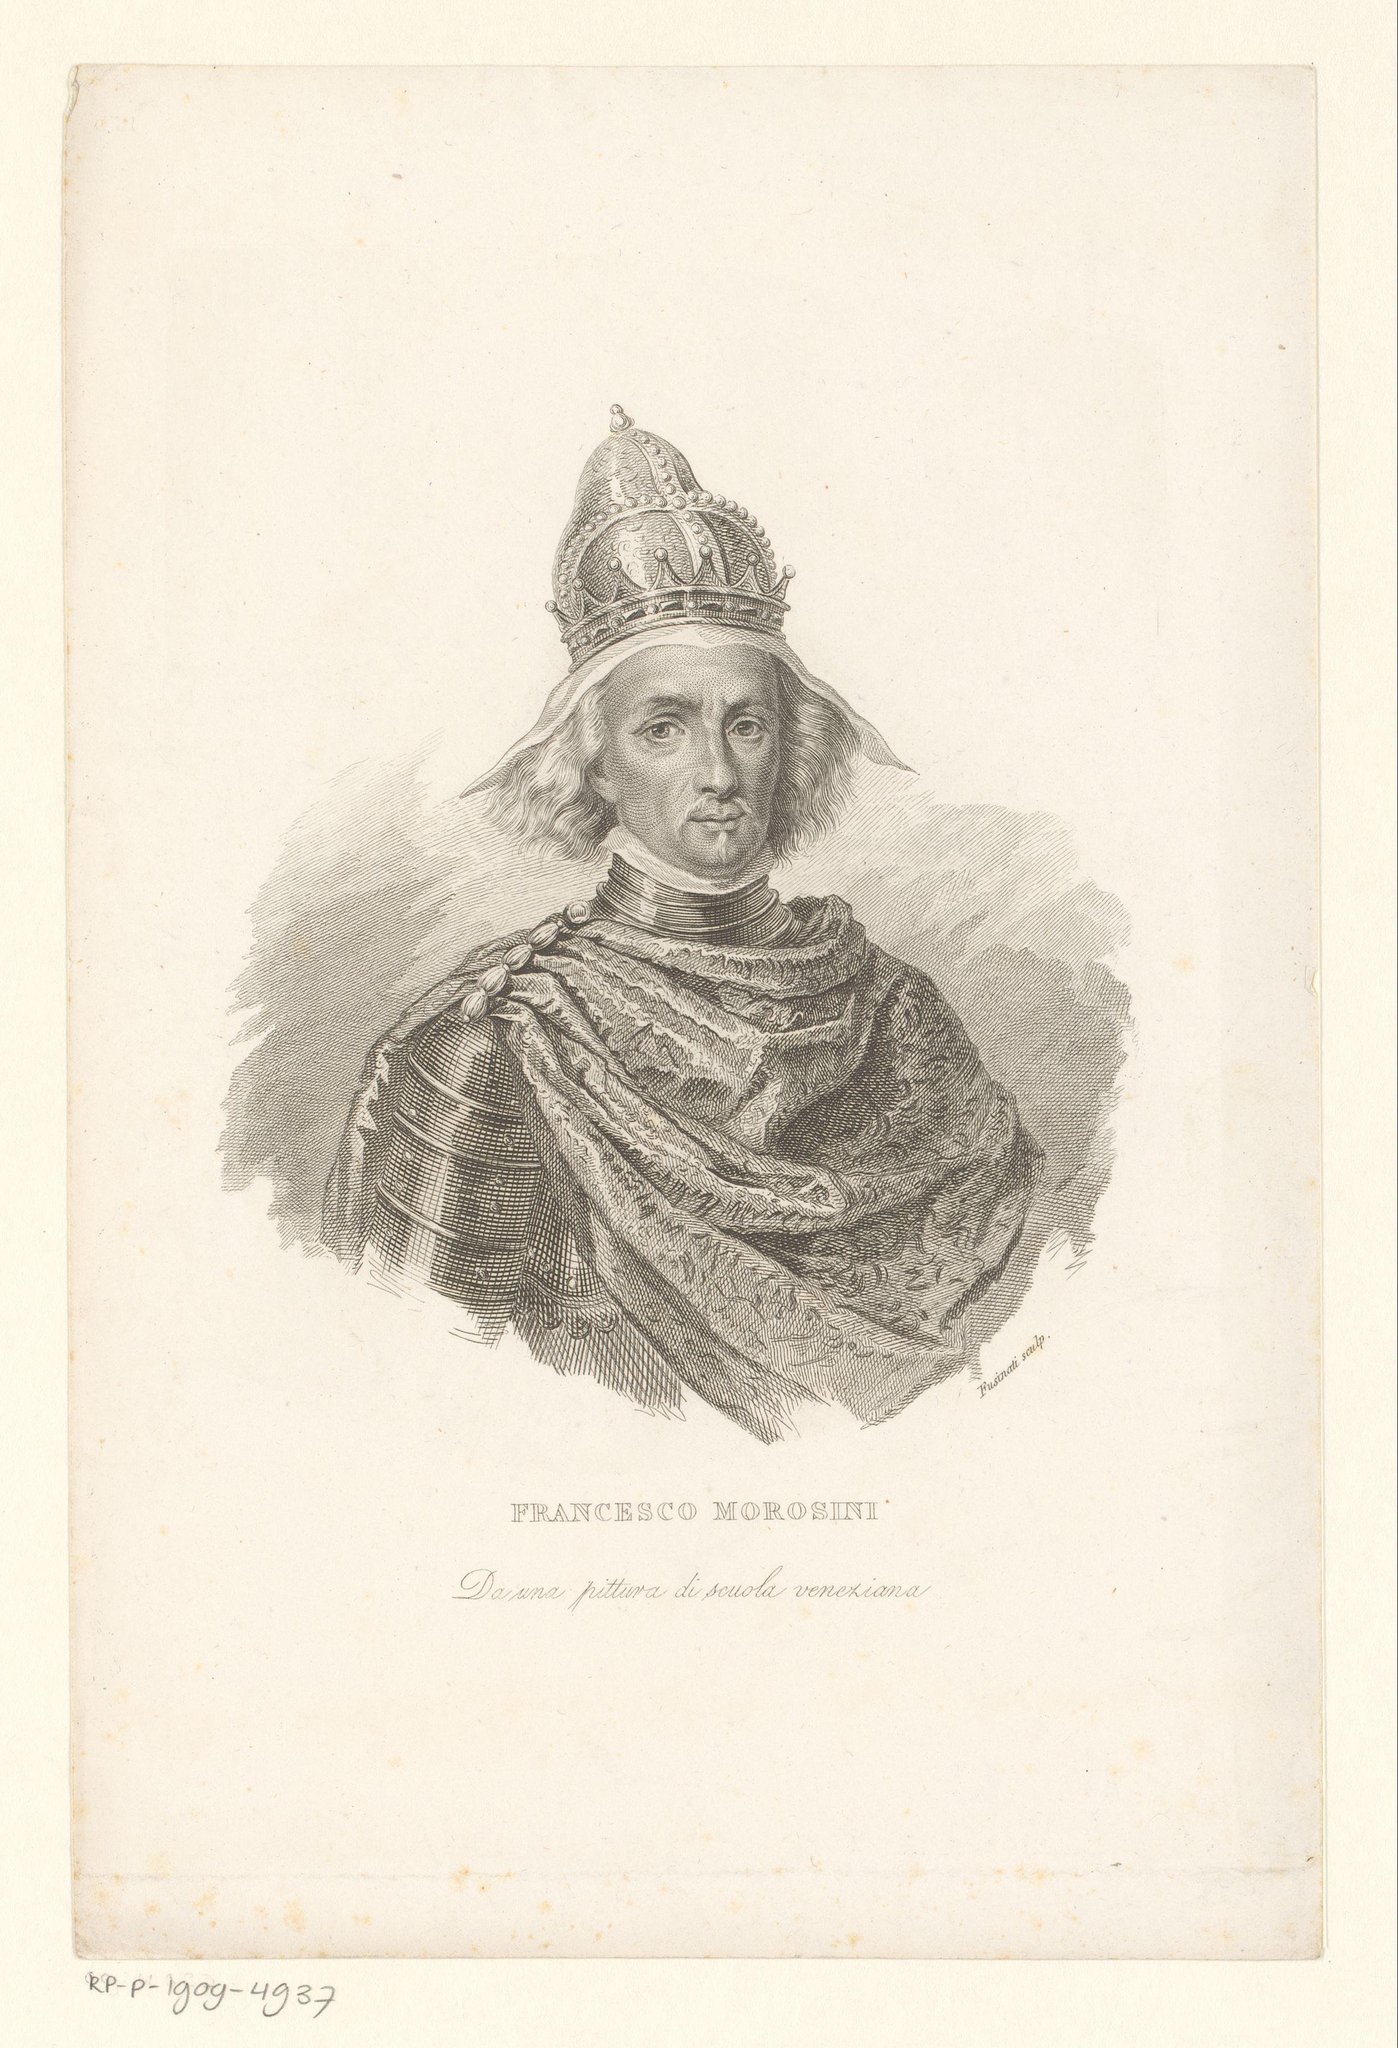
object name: print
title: Portret van Doge Francesco Morosini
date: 1813-1883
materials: paper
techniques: engraving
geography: italy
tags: historical persons, other sovereign: doge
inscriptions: collector's mark: Lugt 2228